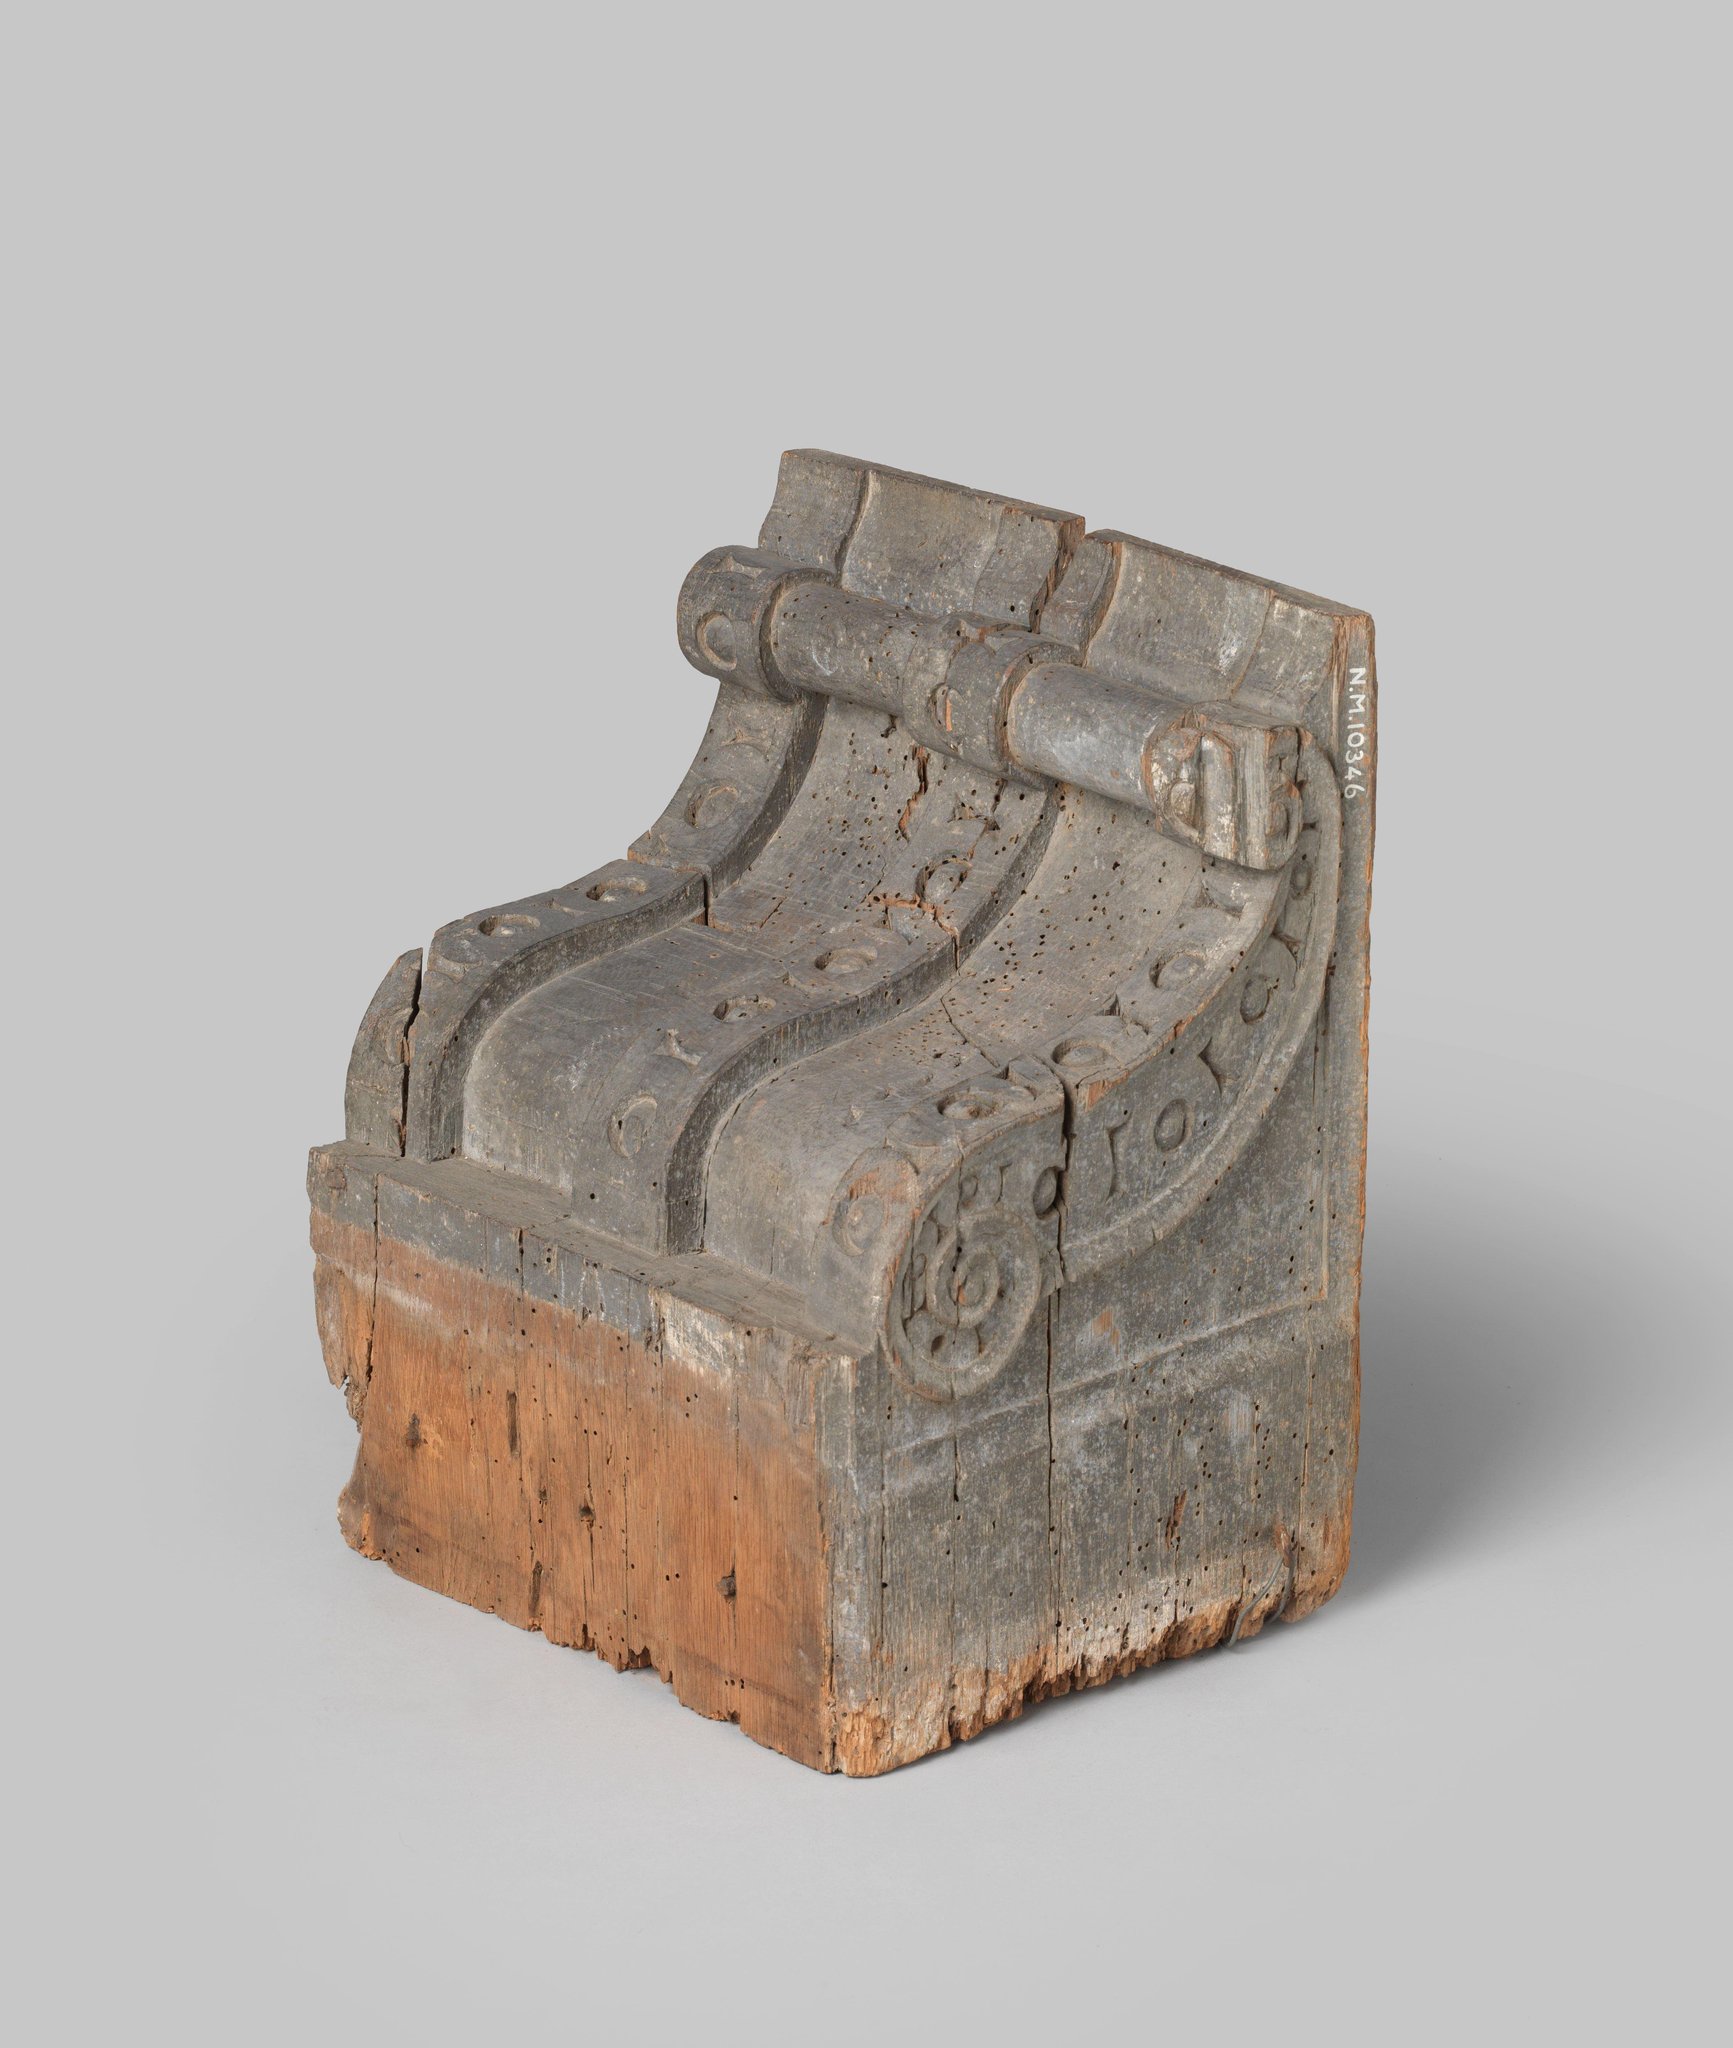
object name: architectural element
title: Sleutelstuk van eikenhout in consolevorm, versierd met drie banden met paarlen en inkepingen.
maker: Anonymous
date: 1500-1600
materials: wood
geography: netherlands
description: Sleutelstuk van eikenhout in consolevorm, versierd met drie banden met paarlen en inkepingen.